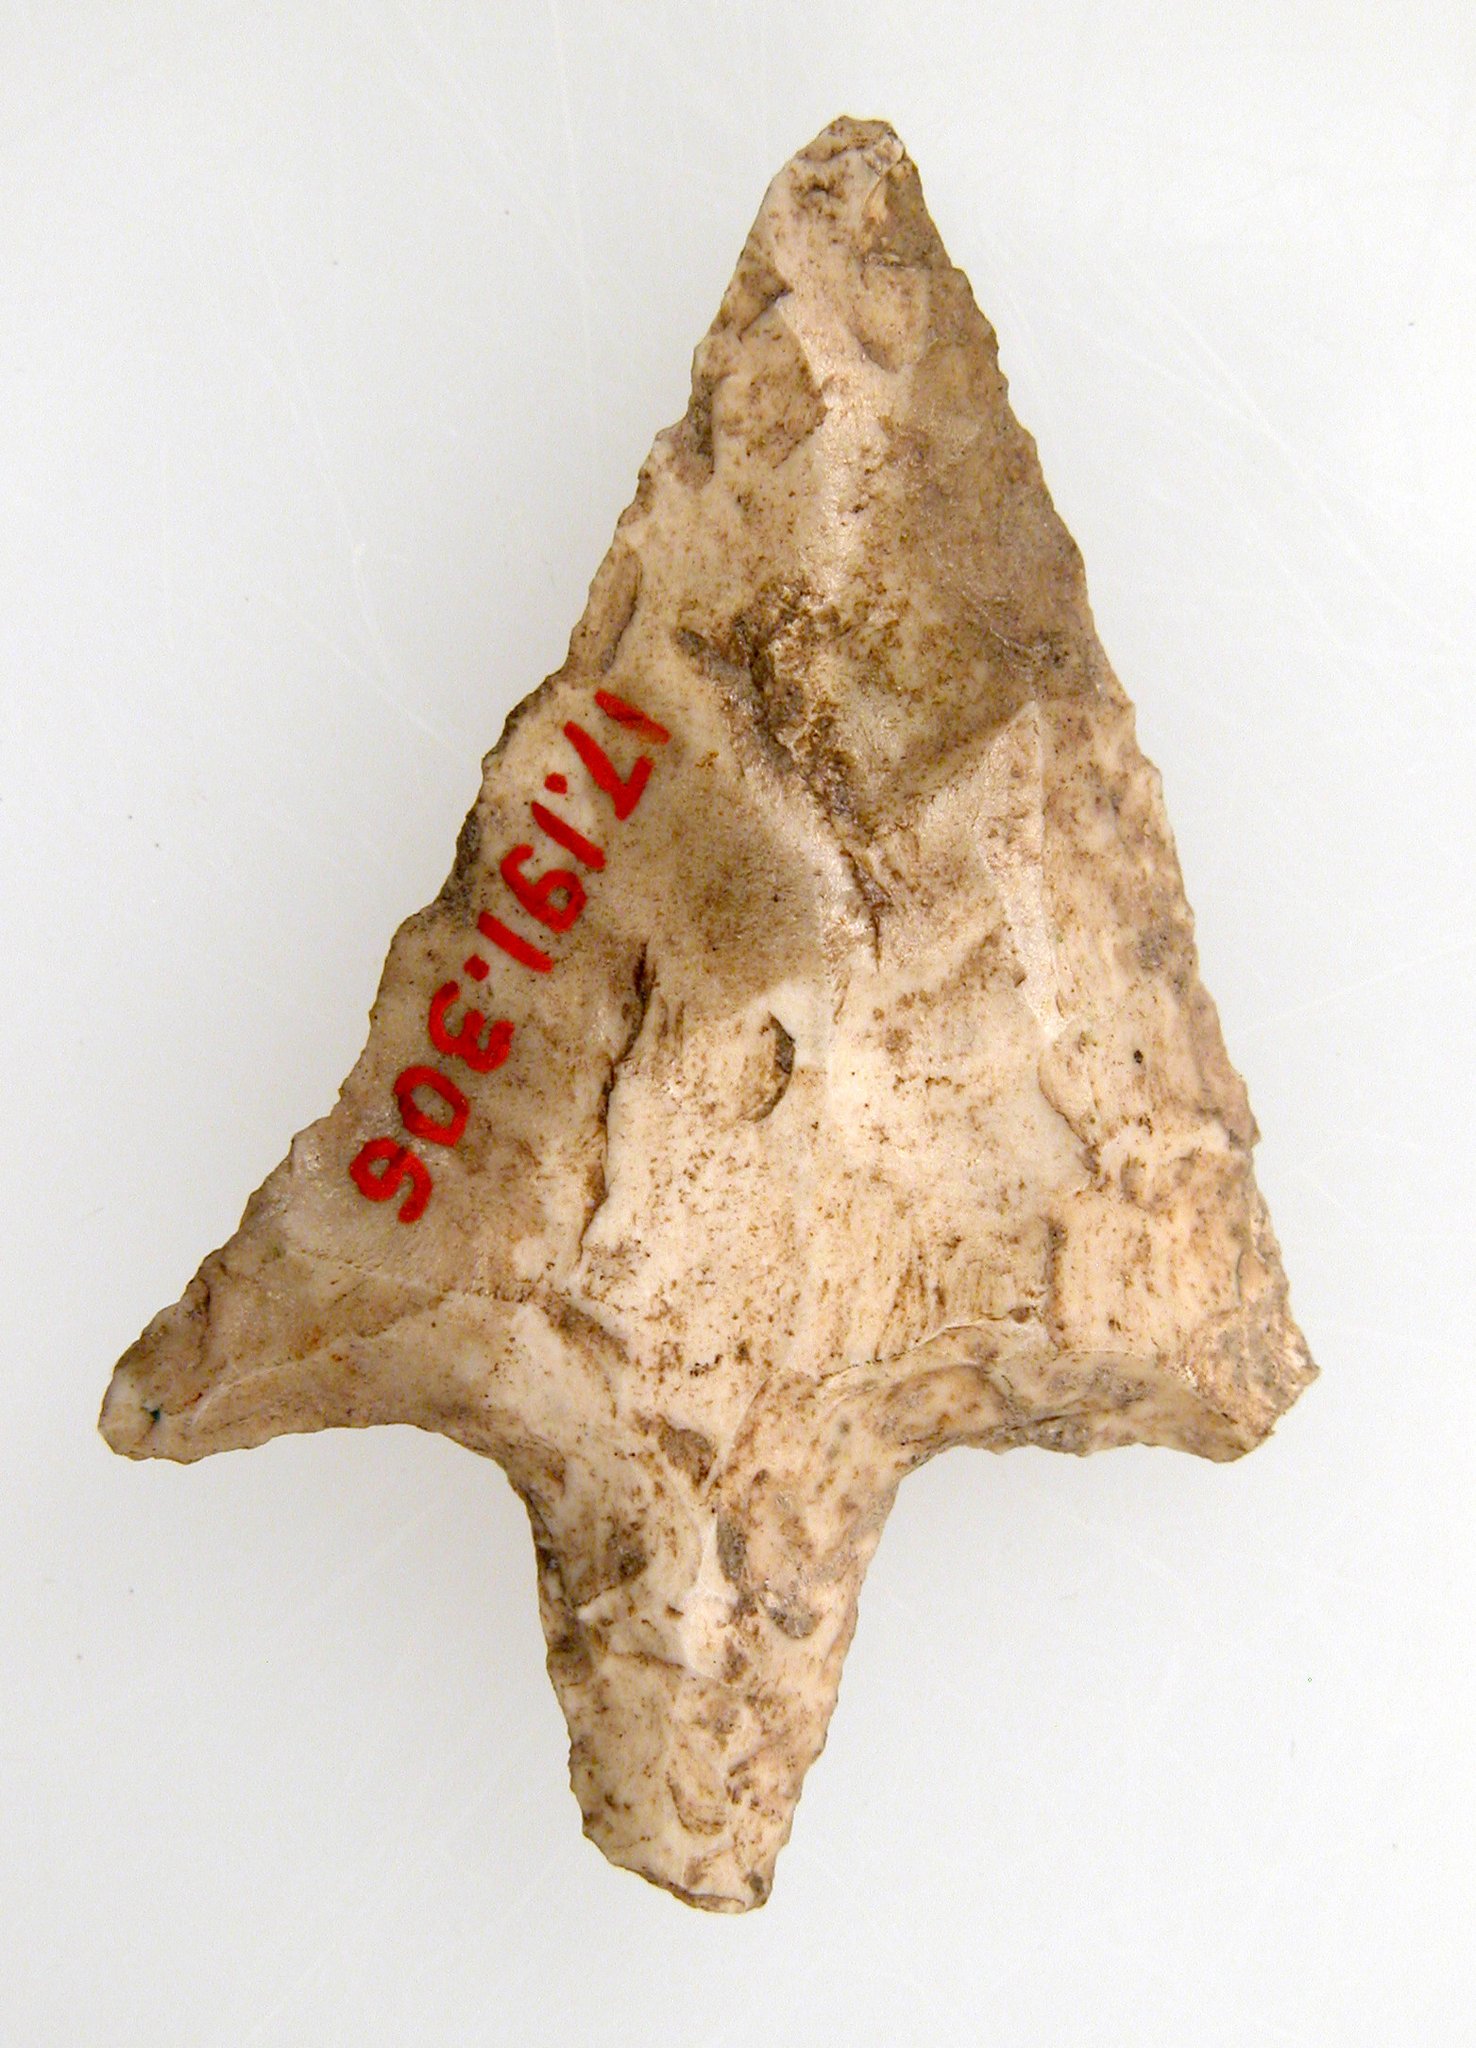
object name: arrowhead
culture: frankish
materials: stone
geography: northern france